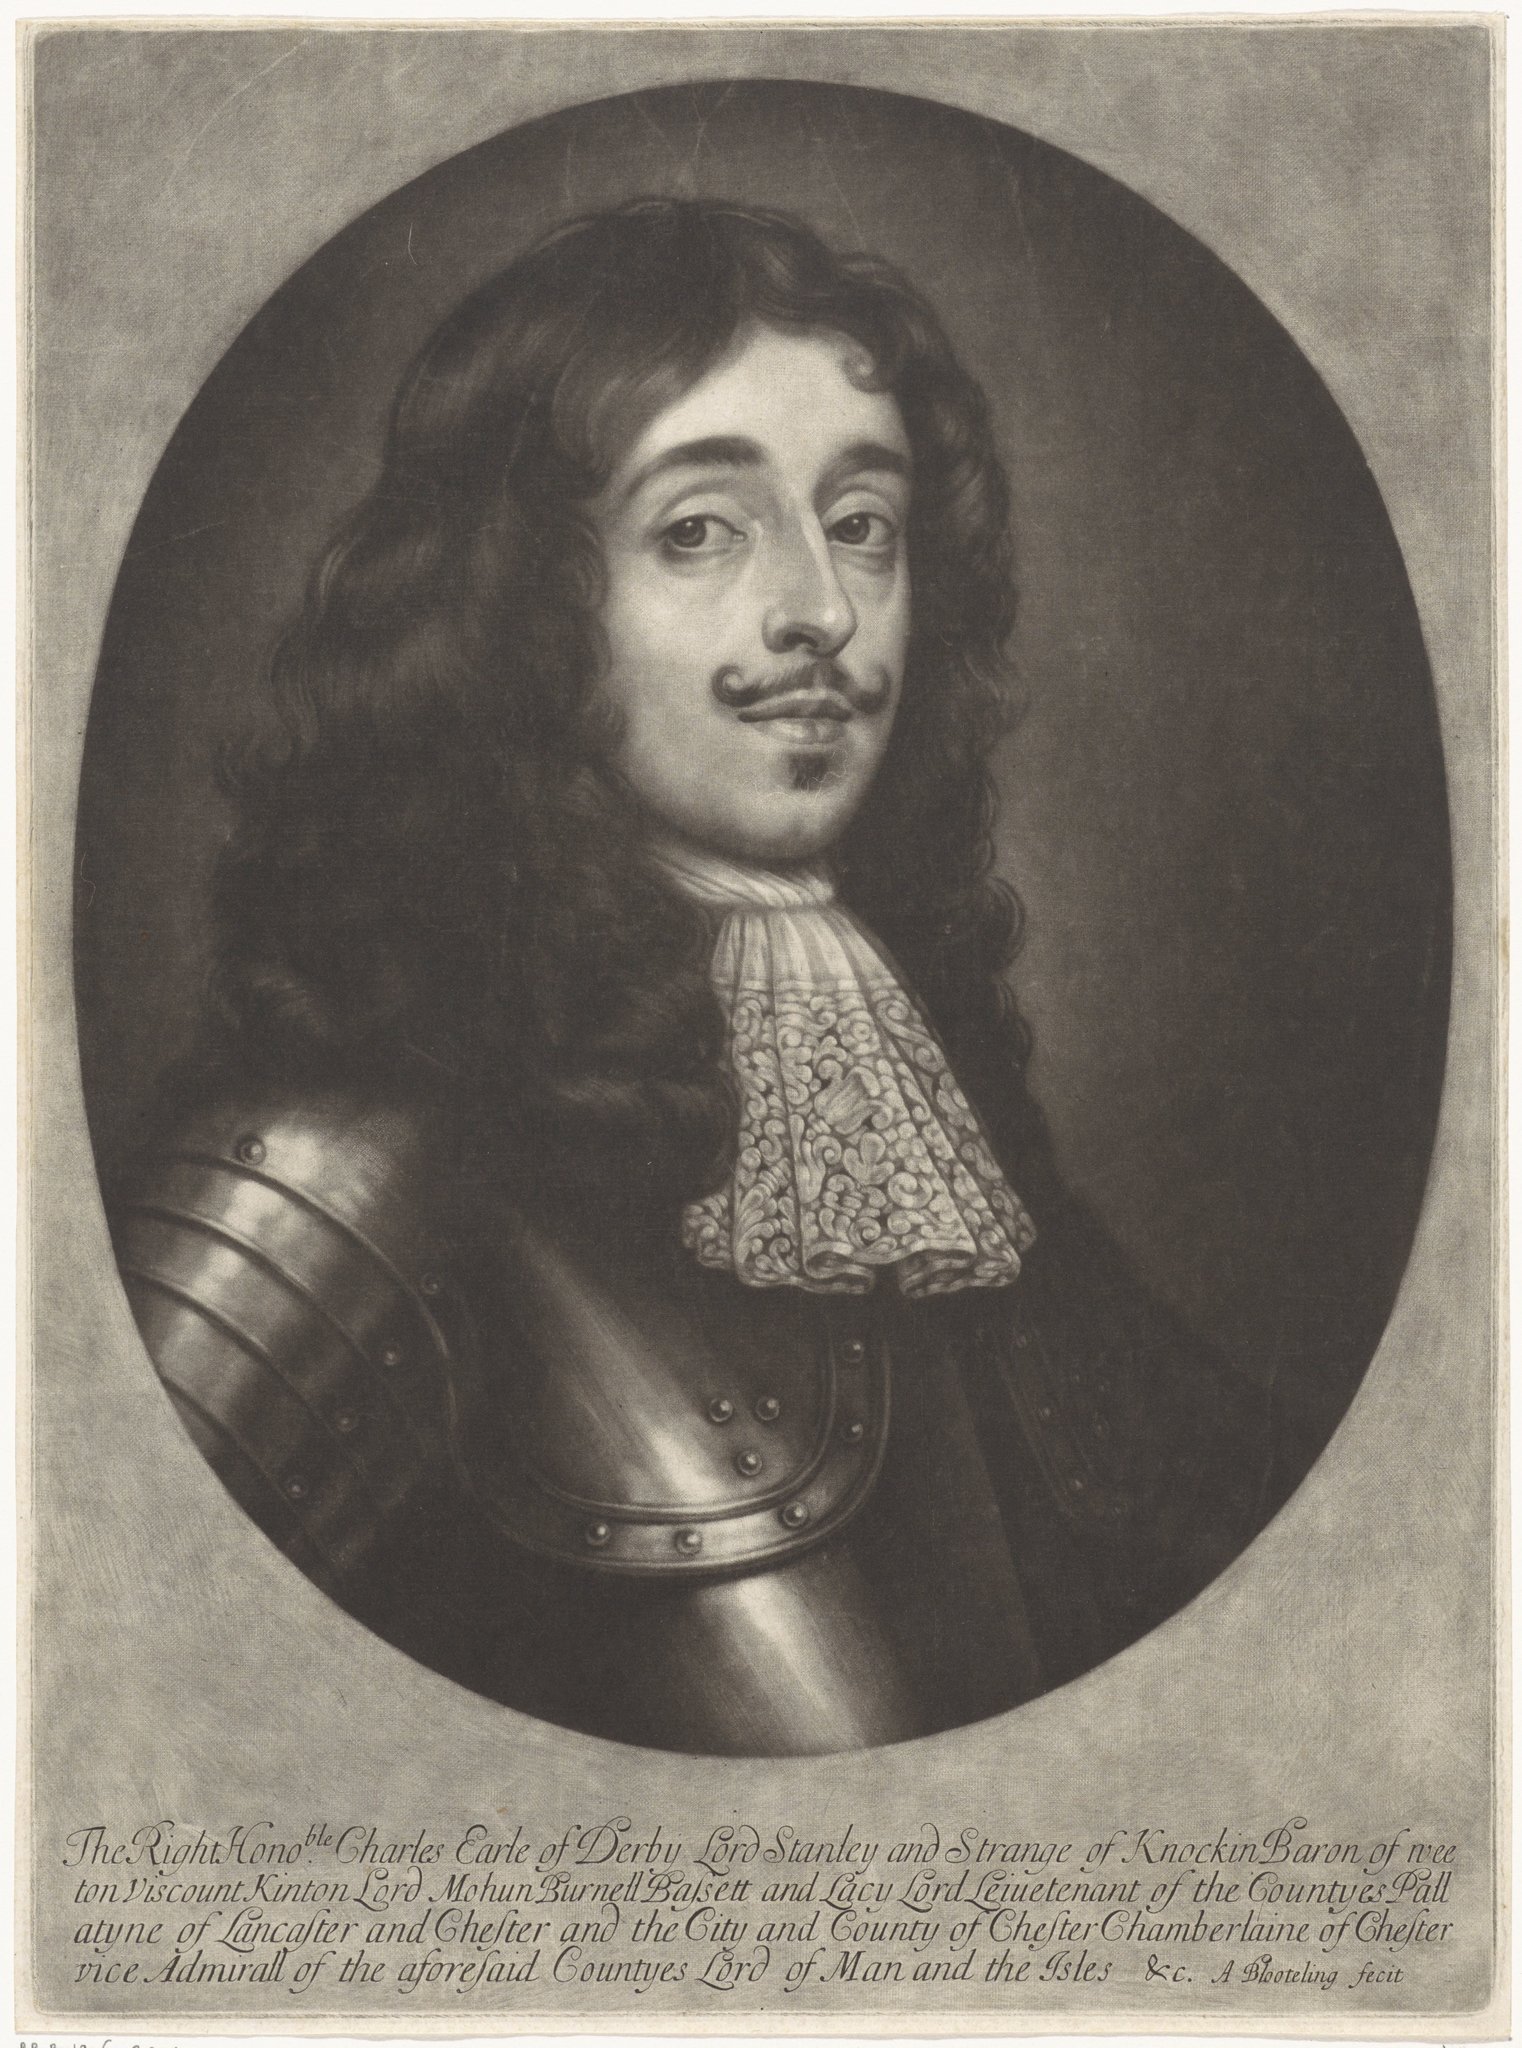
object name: print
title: Portret van Charles Stanley, graaf van Derby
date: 1660-1680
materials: paper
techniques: engraving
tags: charles stanley (graaf van derby)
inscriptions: collector's mark: Lugt 2228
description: Portret van Charles Stanley, graaf van Derby. In de marge zijn naam en titels.